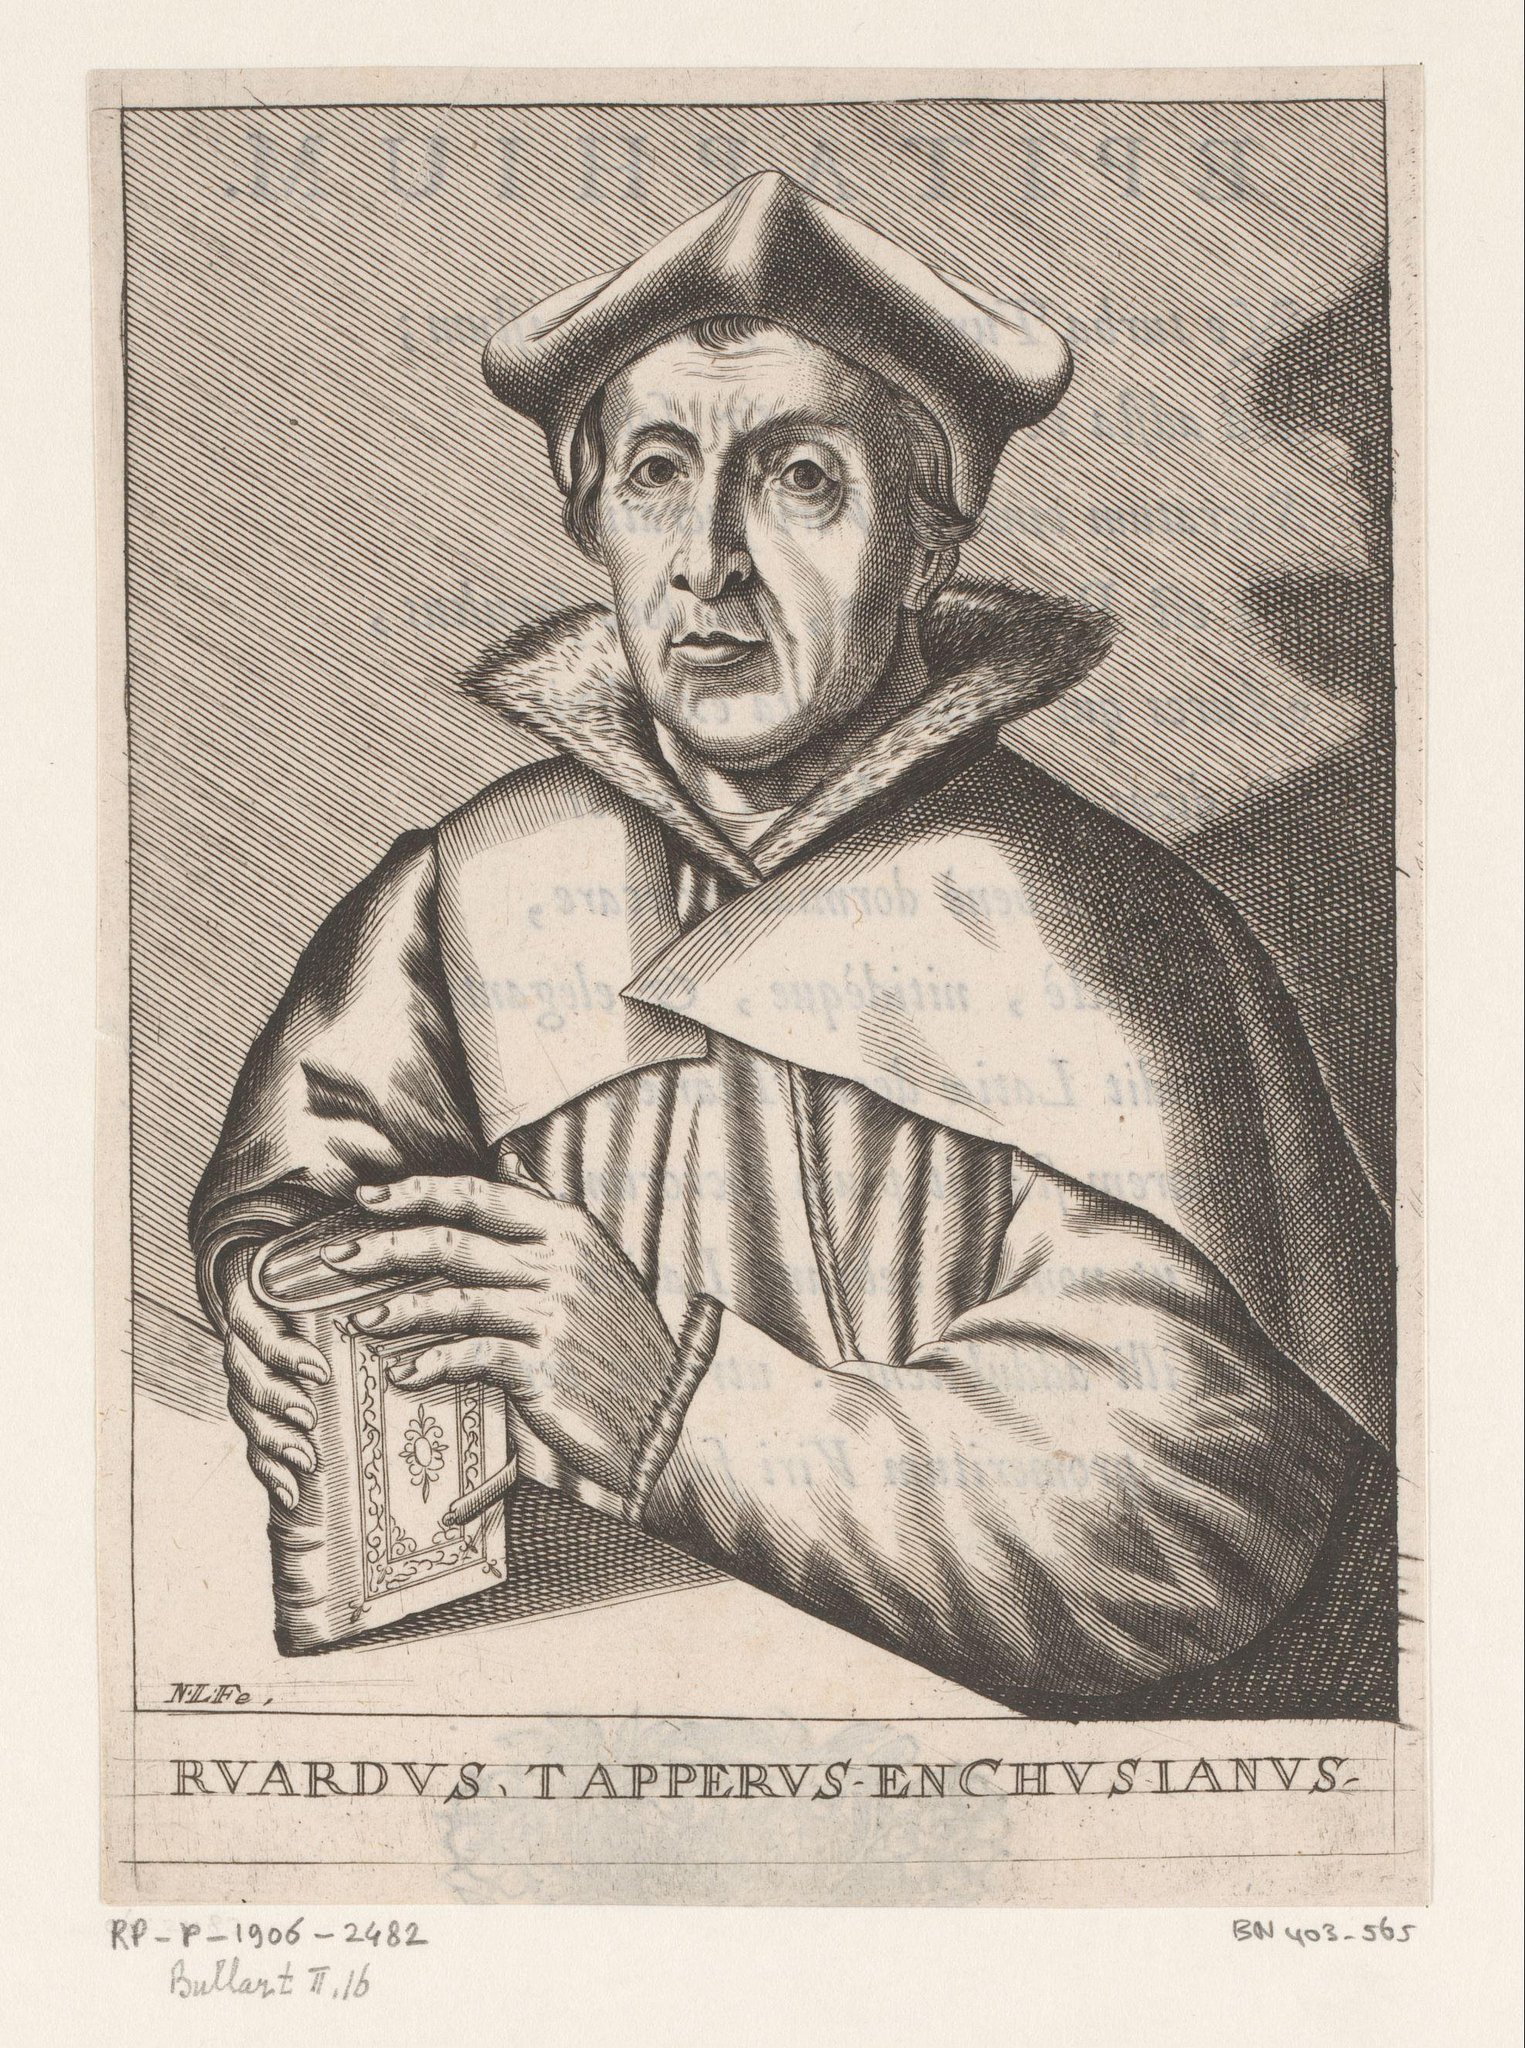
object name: book illustration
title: Portret van Ruard Tapper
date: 1682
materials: paper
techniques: engraving, letterpress printing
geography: brussels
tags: enkhuizen, theologian, historical persons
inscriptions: collector's mark: Lugt 2228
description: Prent gebruikt voor: Bullart, Isaac. Académie des Sciences et Arts contenant les vies et éloges his. des hommes illustres qui ont excellé en ces professions depuis environ quatre siècles. Brussel: François Foppens, 1682. Het boek werd in 1682 eveneens in Amsterdam uitgegeven door de erfgenamen van Daniel Elzevier. Ieder portret betreft een illustratie bij de biografie van een kunstenaar of geleerde. De meeste portretten werden door Nicolas de Larmessin vervaardigd (162), 93 door De Boulonois en een derde door ongeïdentificeerde prentmakers. Dit betreft een illustratie op p. 16, deel II.